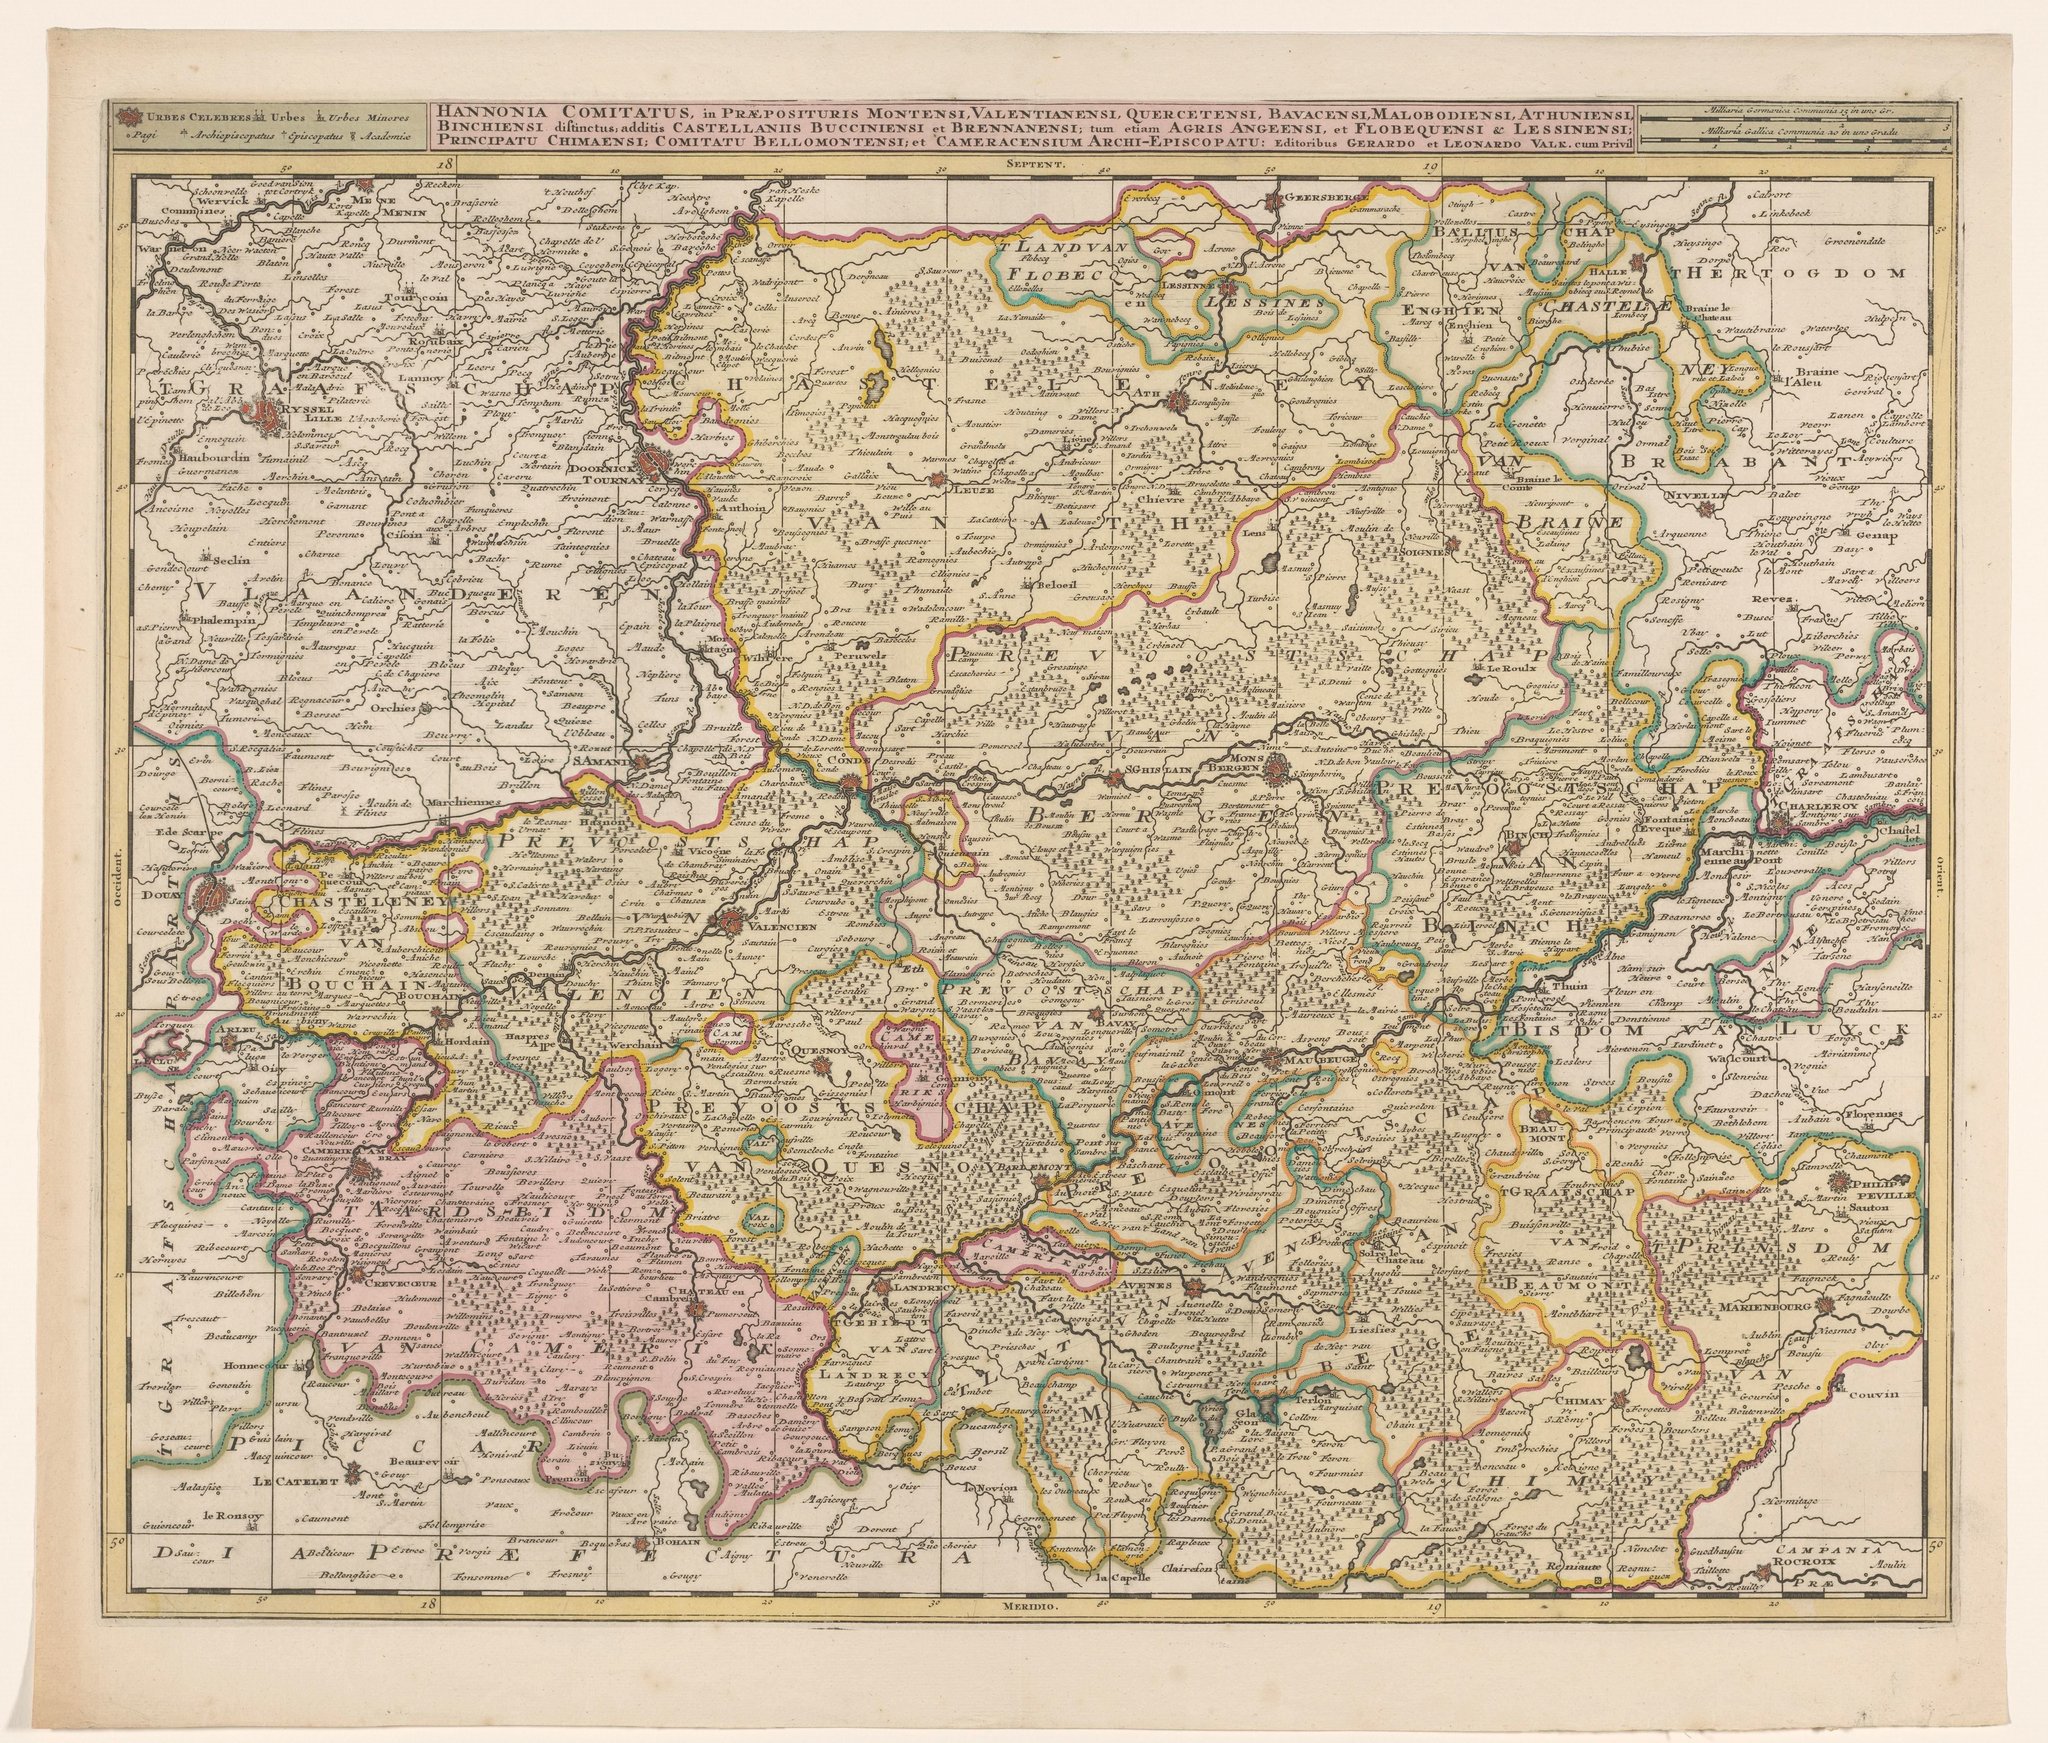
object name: print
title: Hannonia comitatus, in praeposituris Montensi, Valentianensi, Quercetensi (...)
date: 1710-1746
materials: paper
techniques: engraving, hand coloring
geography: amsterdam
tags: maps of separate countries or regions, henegouwen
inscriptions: collector's mark: Lugt 2228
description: Kaart van het graafschap Henegouwen. In een balk boven de kaart, in het midden, de titel. Links hiervan een legenda. Rechts van de titel twee schaalstokken: 3 Milliaria Germanica Communia 15 in uno Gr. / 4 Milliaria Gallica Communia 20 in uno Gradu. De kaart is voorzien van een coördinaten-net en een gradenverdeling.